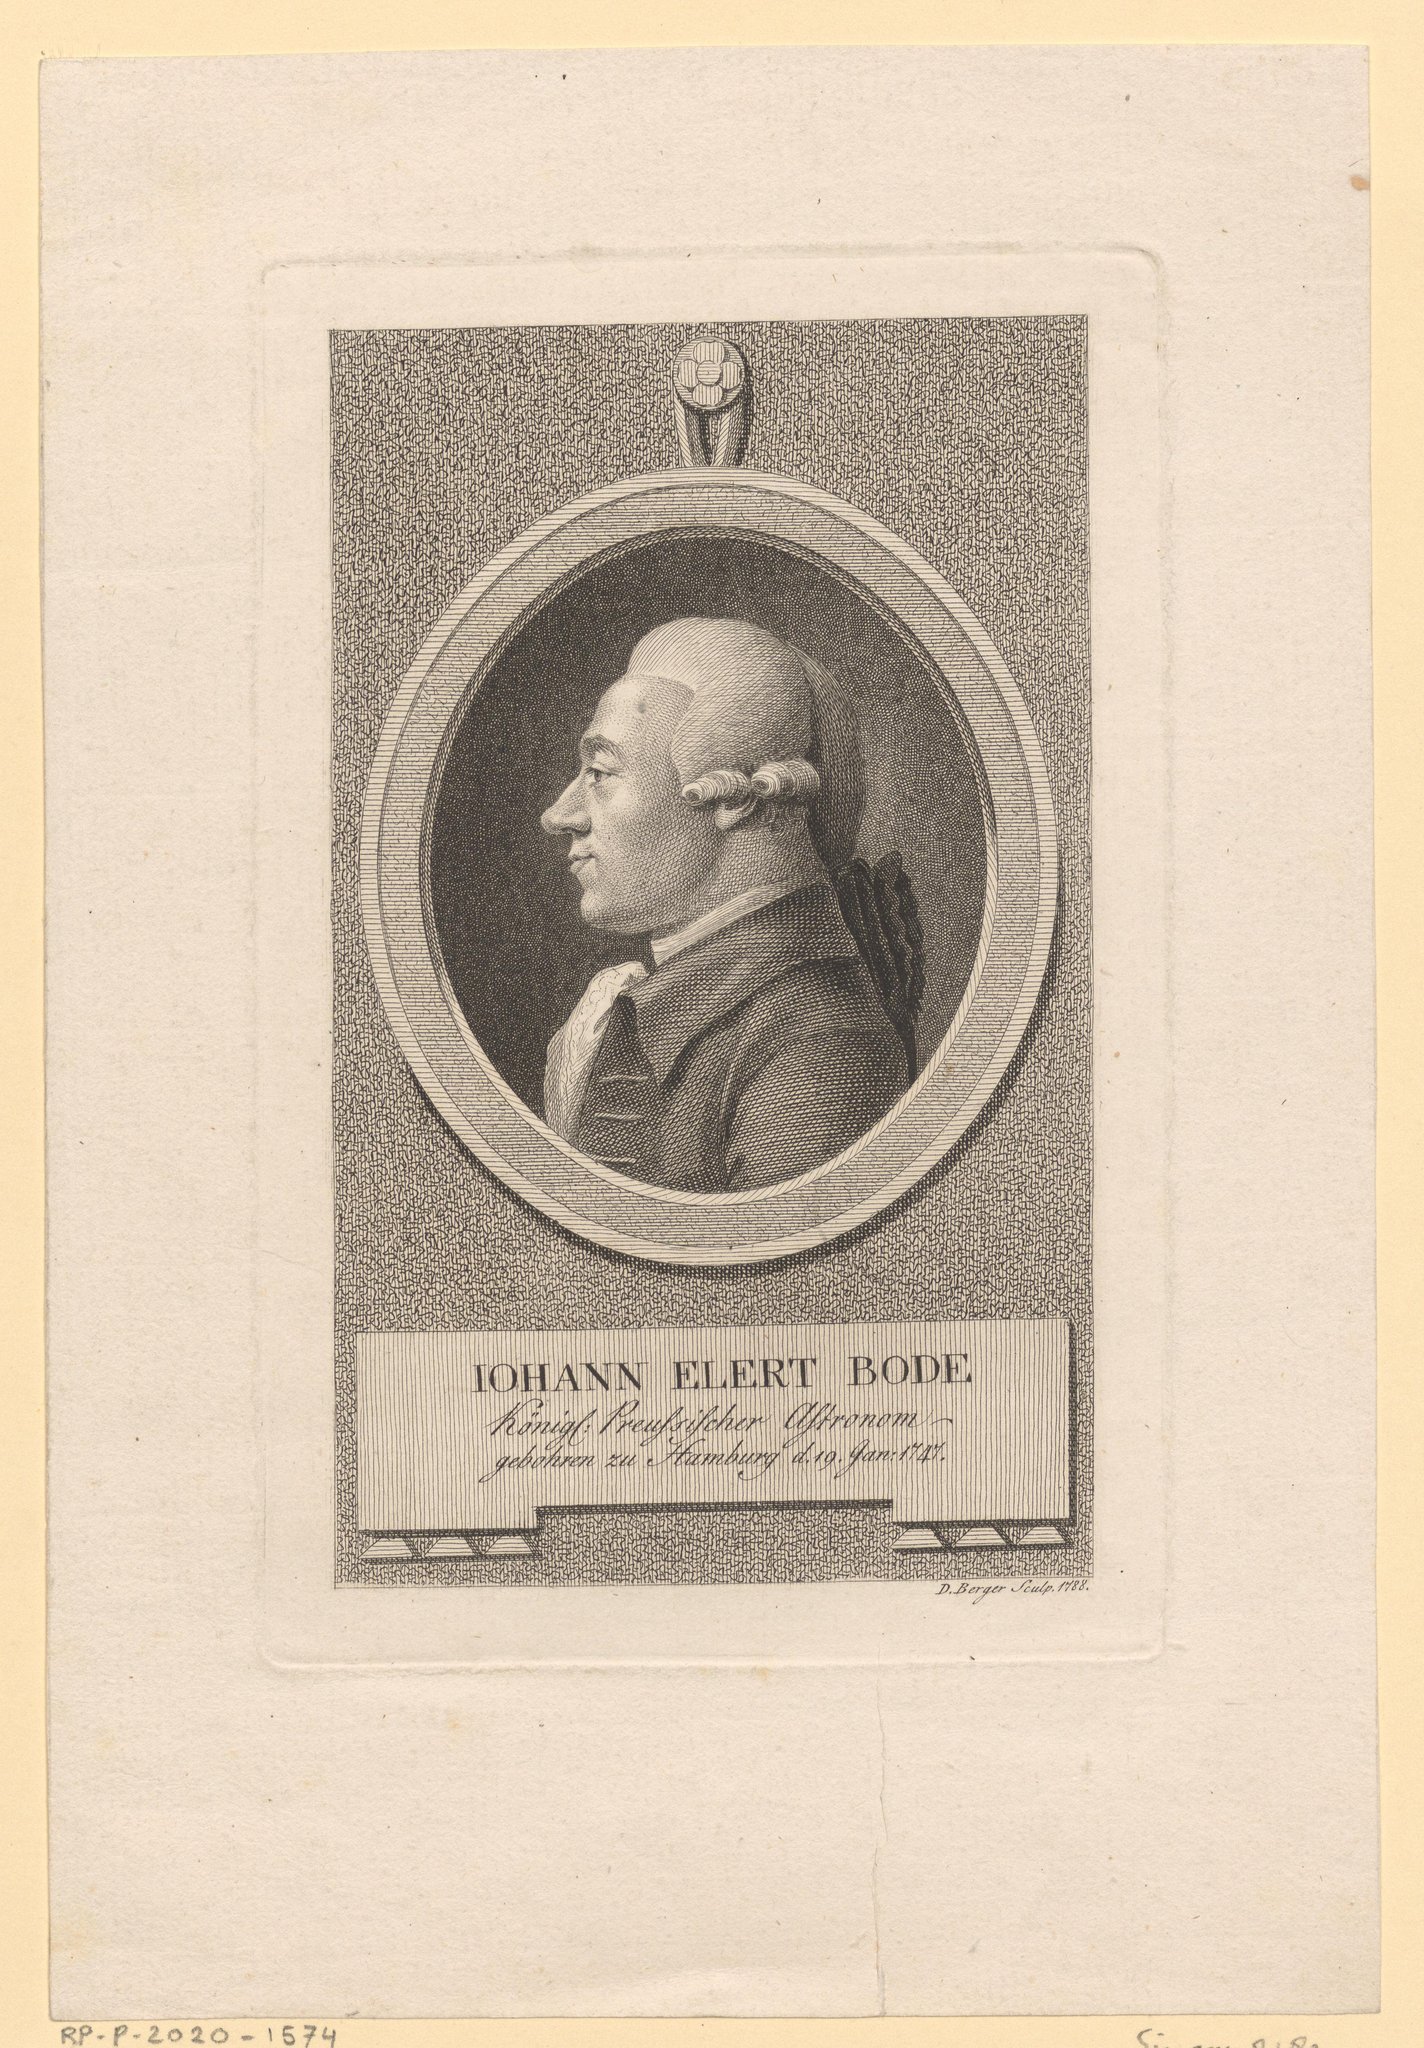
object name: print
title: Portret van Johann Elert Bode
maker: daniel berger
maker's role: print maker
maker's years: 1744-1824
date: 1788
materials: paper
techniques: engraving, etching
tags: berlin, scholar, philosopher, historical persons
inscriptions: date